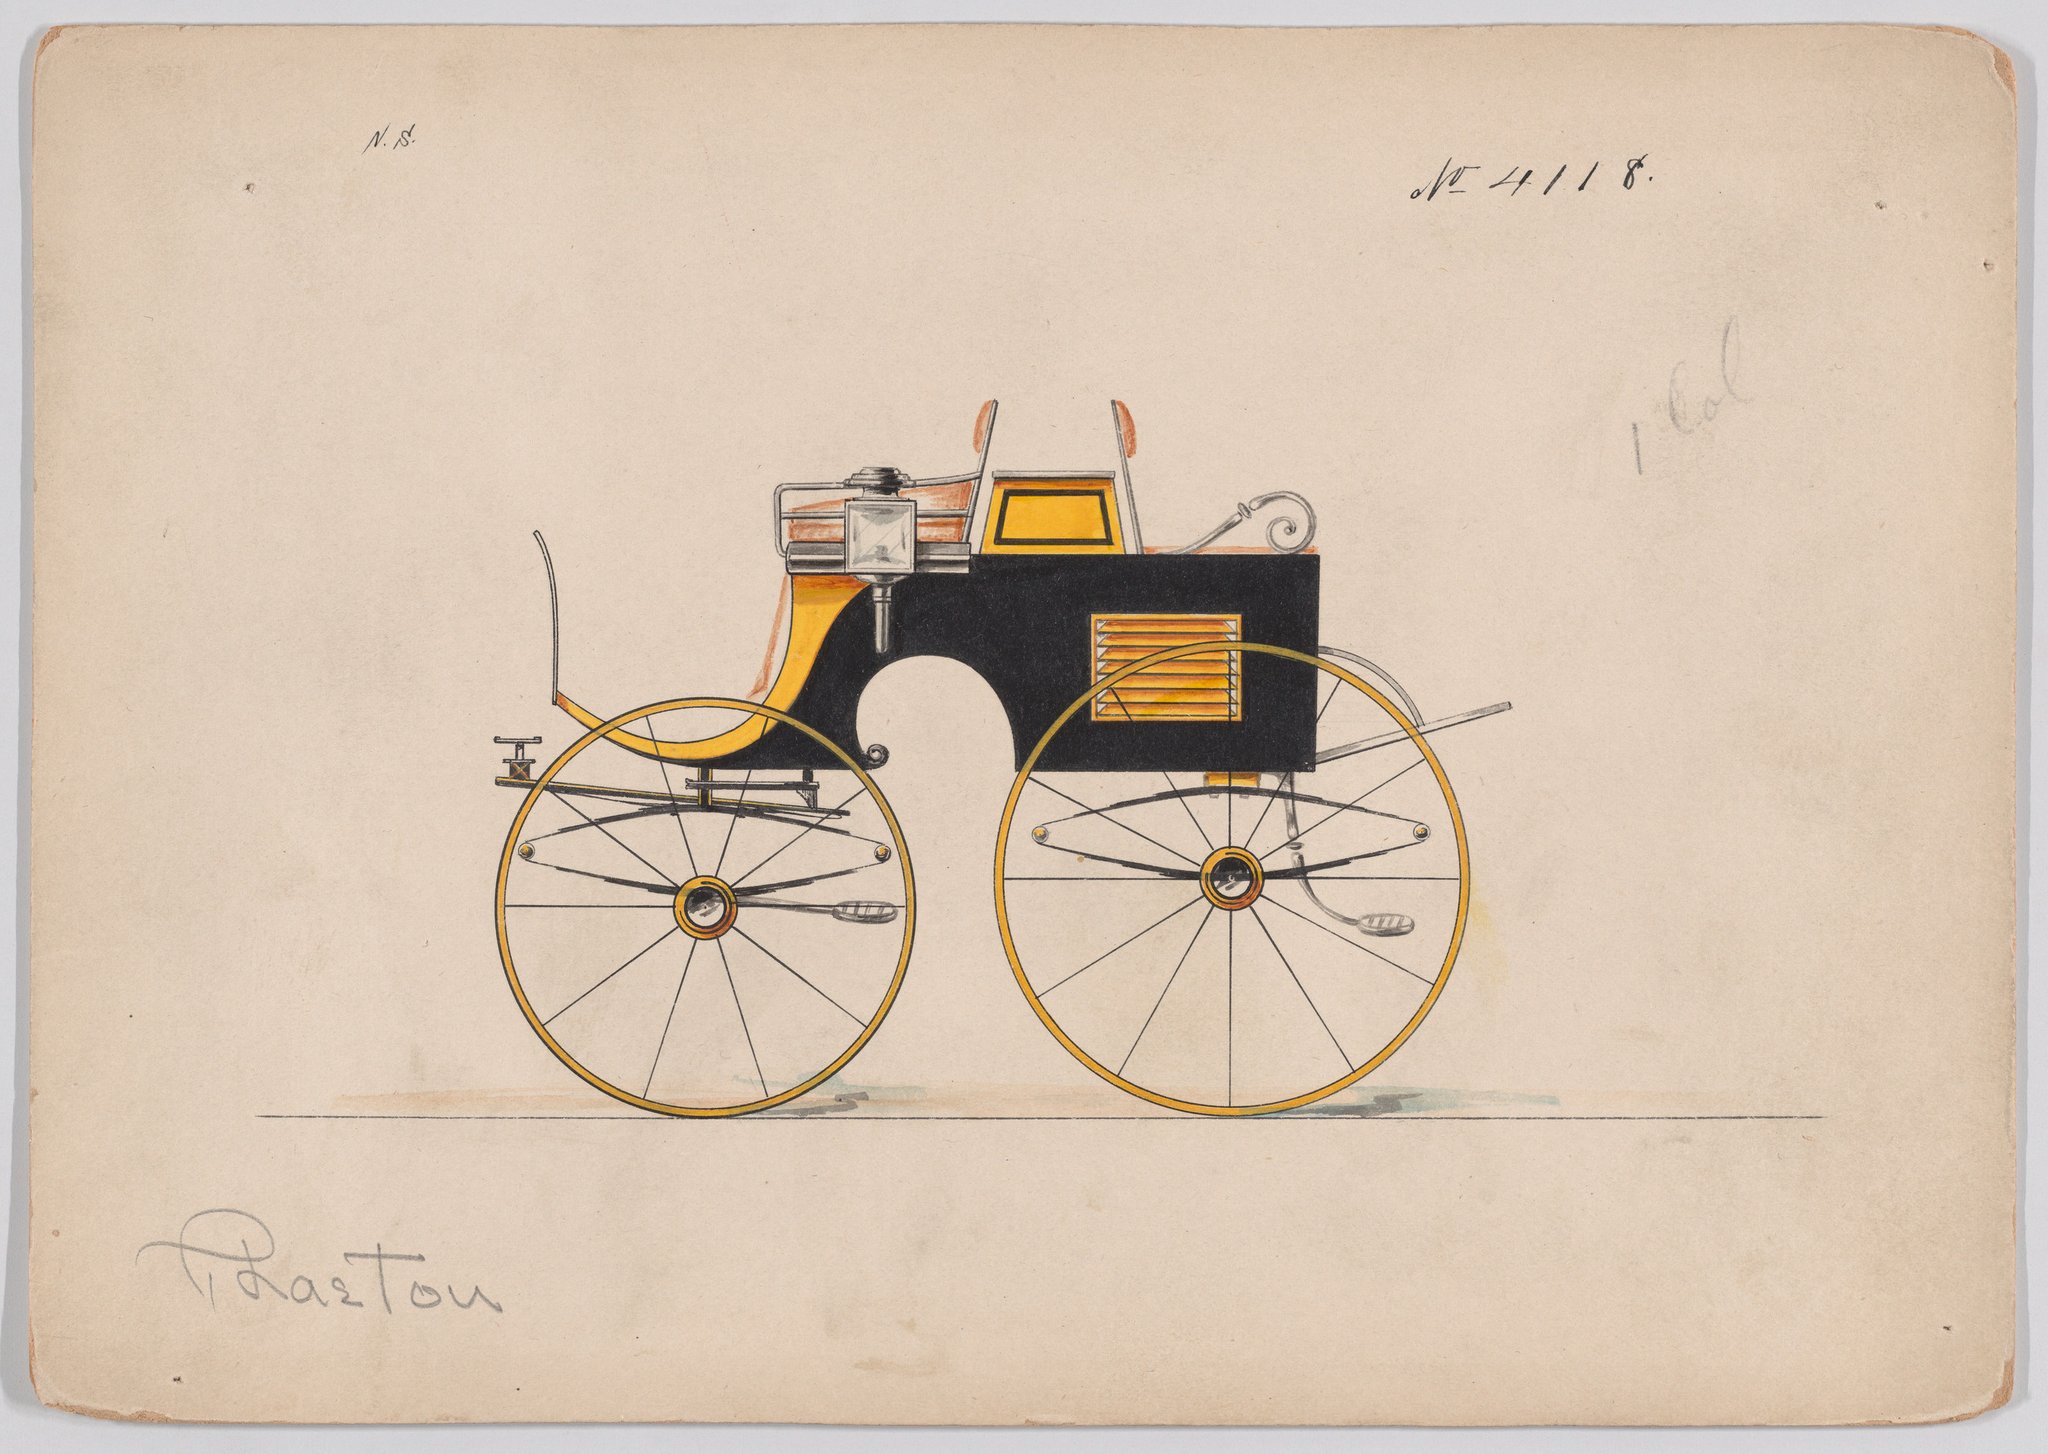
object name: drawing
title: Dog Cart Phaeton/Four Wheel Tandem Cart # 4118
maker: brewster & co.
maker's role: manufacturer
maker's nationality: american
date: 1891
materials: gouache, gum arabic, ink, watercolor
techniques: pen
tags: carriages